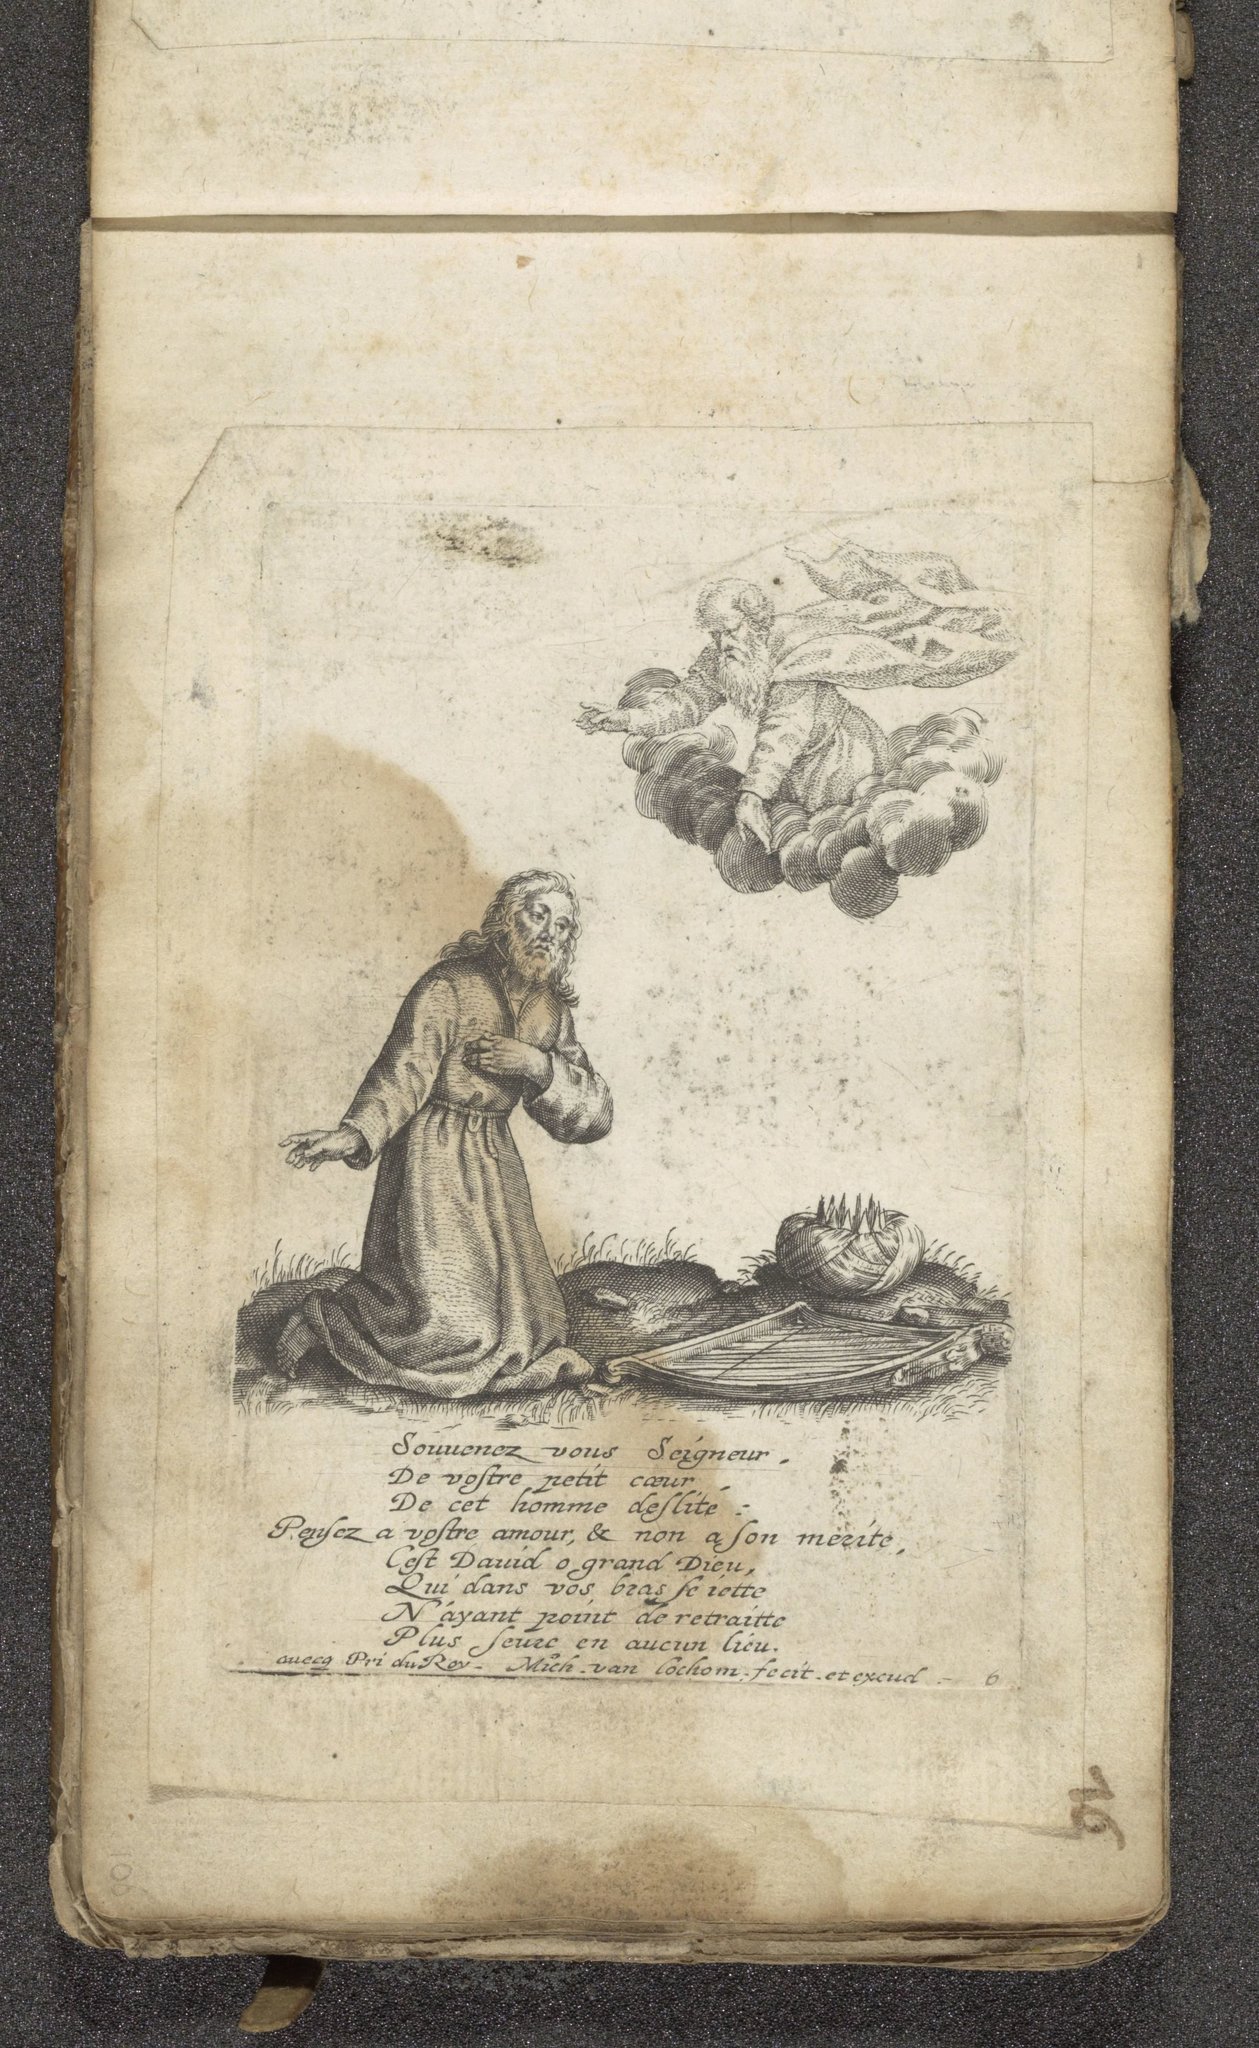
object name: album leaf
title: David disgracié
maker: michel van lochom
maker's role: print maker, publisher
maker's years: 1601-1647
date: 1625-1647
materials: paper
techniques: engraving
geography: paris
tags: story of david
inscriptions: inscription: ‘76’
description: Als boeteling zit David op zijn knieën voor God in de wolken. Voor David liggen zijn kroon en harp. De prent maakt deel uit van een album.